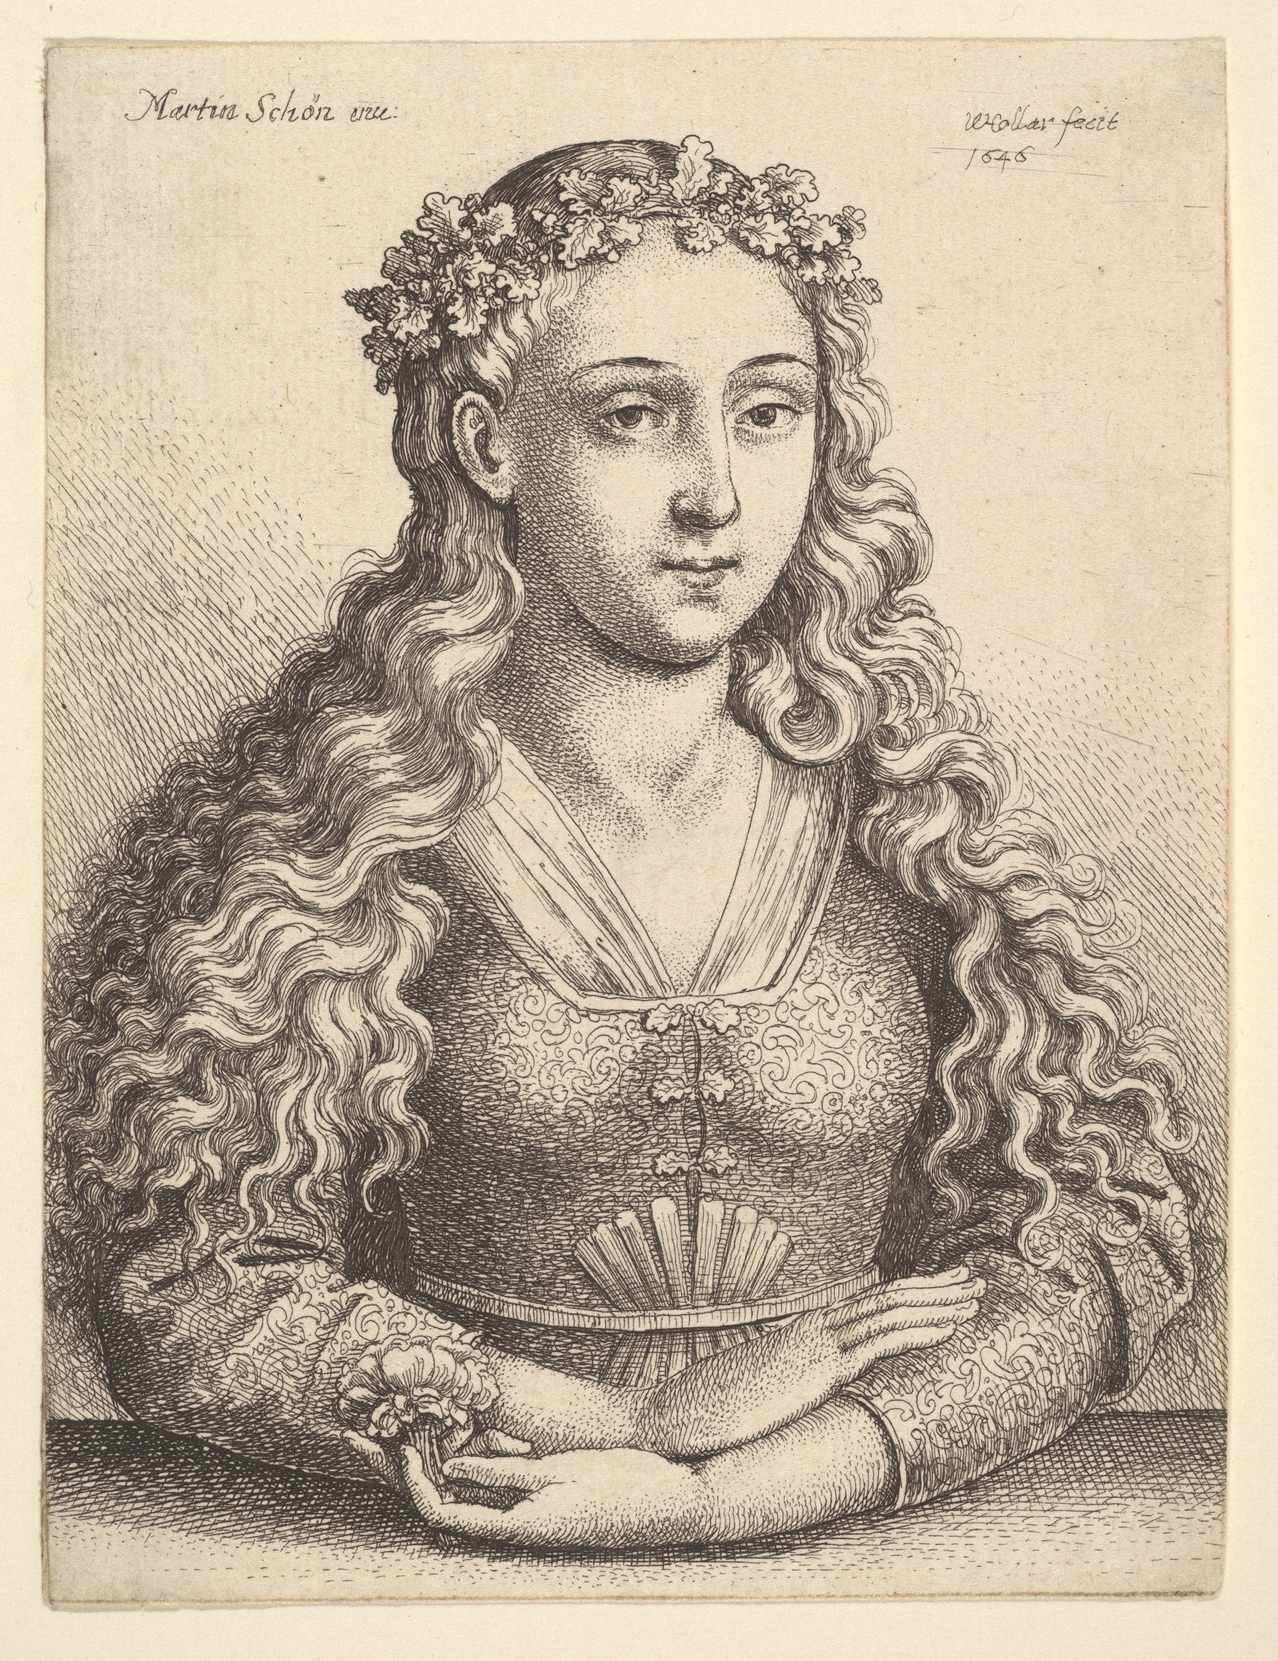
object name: print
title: Woman with a wreath of oak leaves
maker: wenceslaus hollar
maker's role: artist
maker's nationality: bohemian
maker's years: 1607-1677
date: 1646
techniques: cutting, etching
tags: portraits,women,leaves,oaks,wreaths